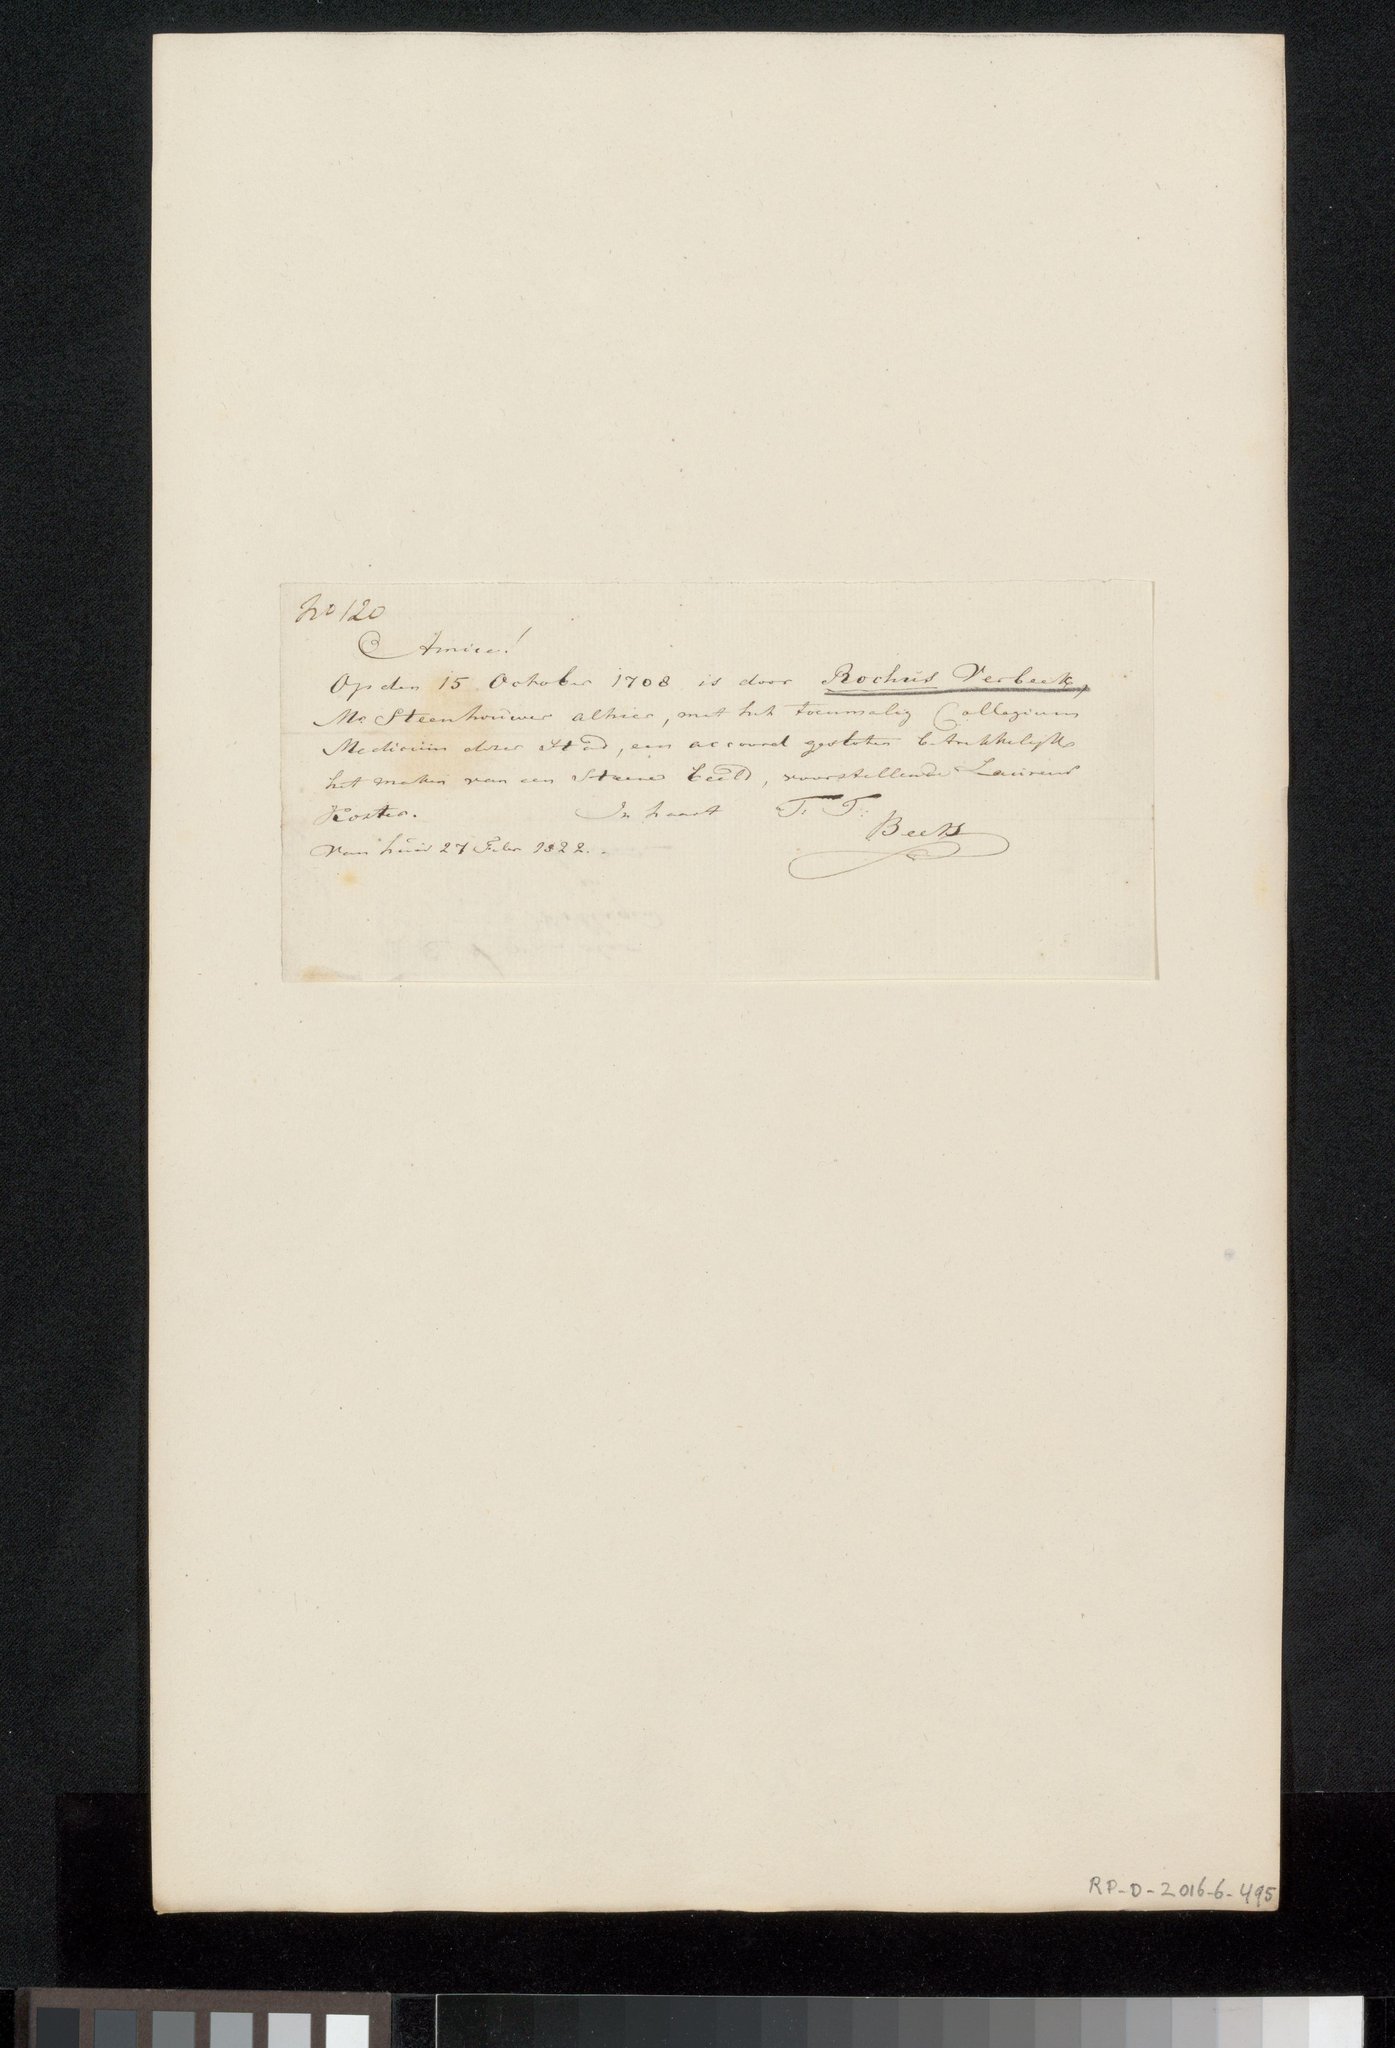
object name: letter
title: Brief aan Adriaan van der Willigen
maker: johannes jacobus beets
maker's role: publisher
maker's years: 1767-1844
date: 1822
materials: ink, paper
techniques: pen, writing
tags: rotterdam, haarlem, draughtsman, adriaan van der willigen